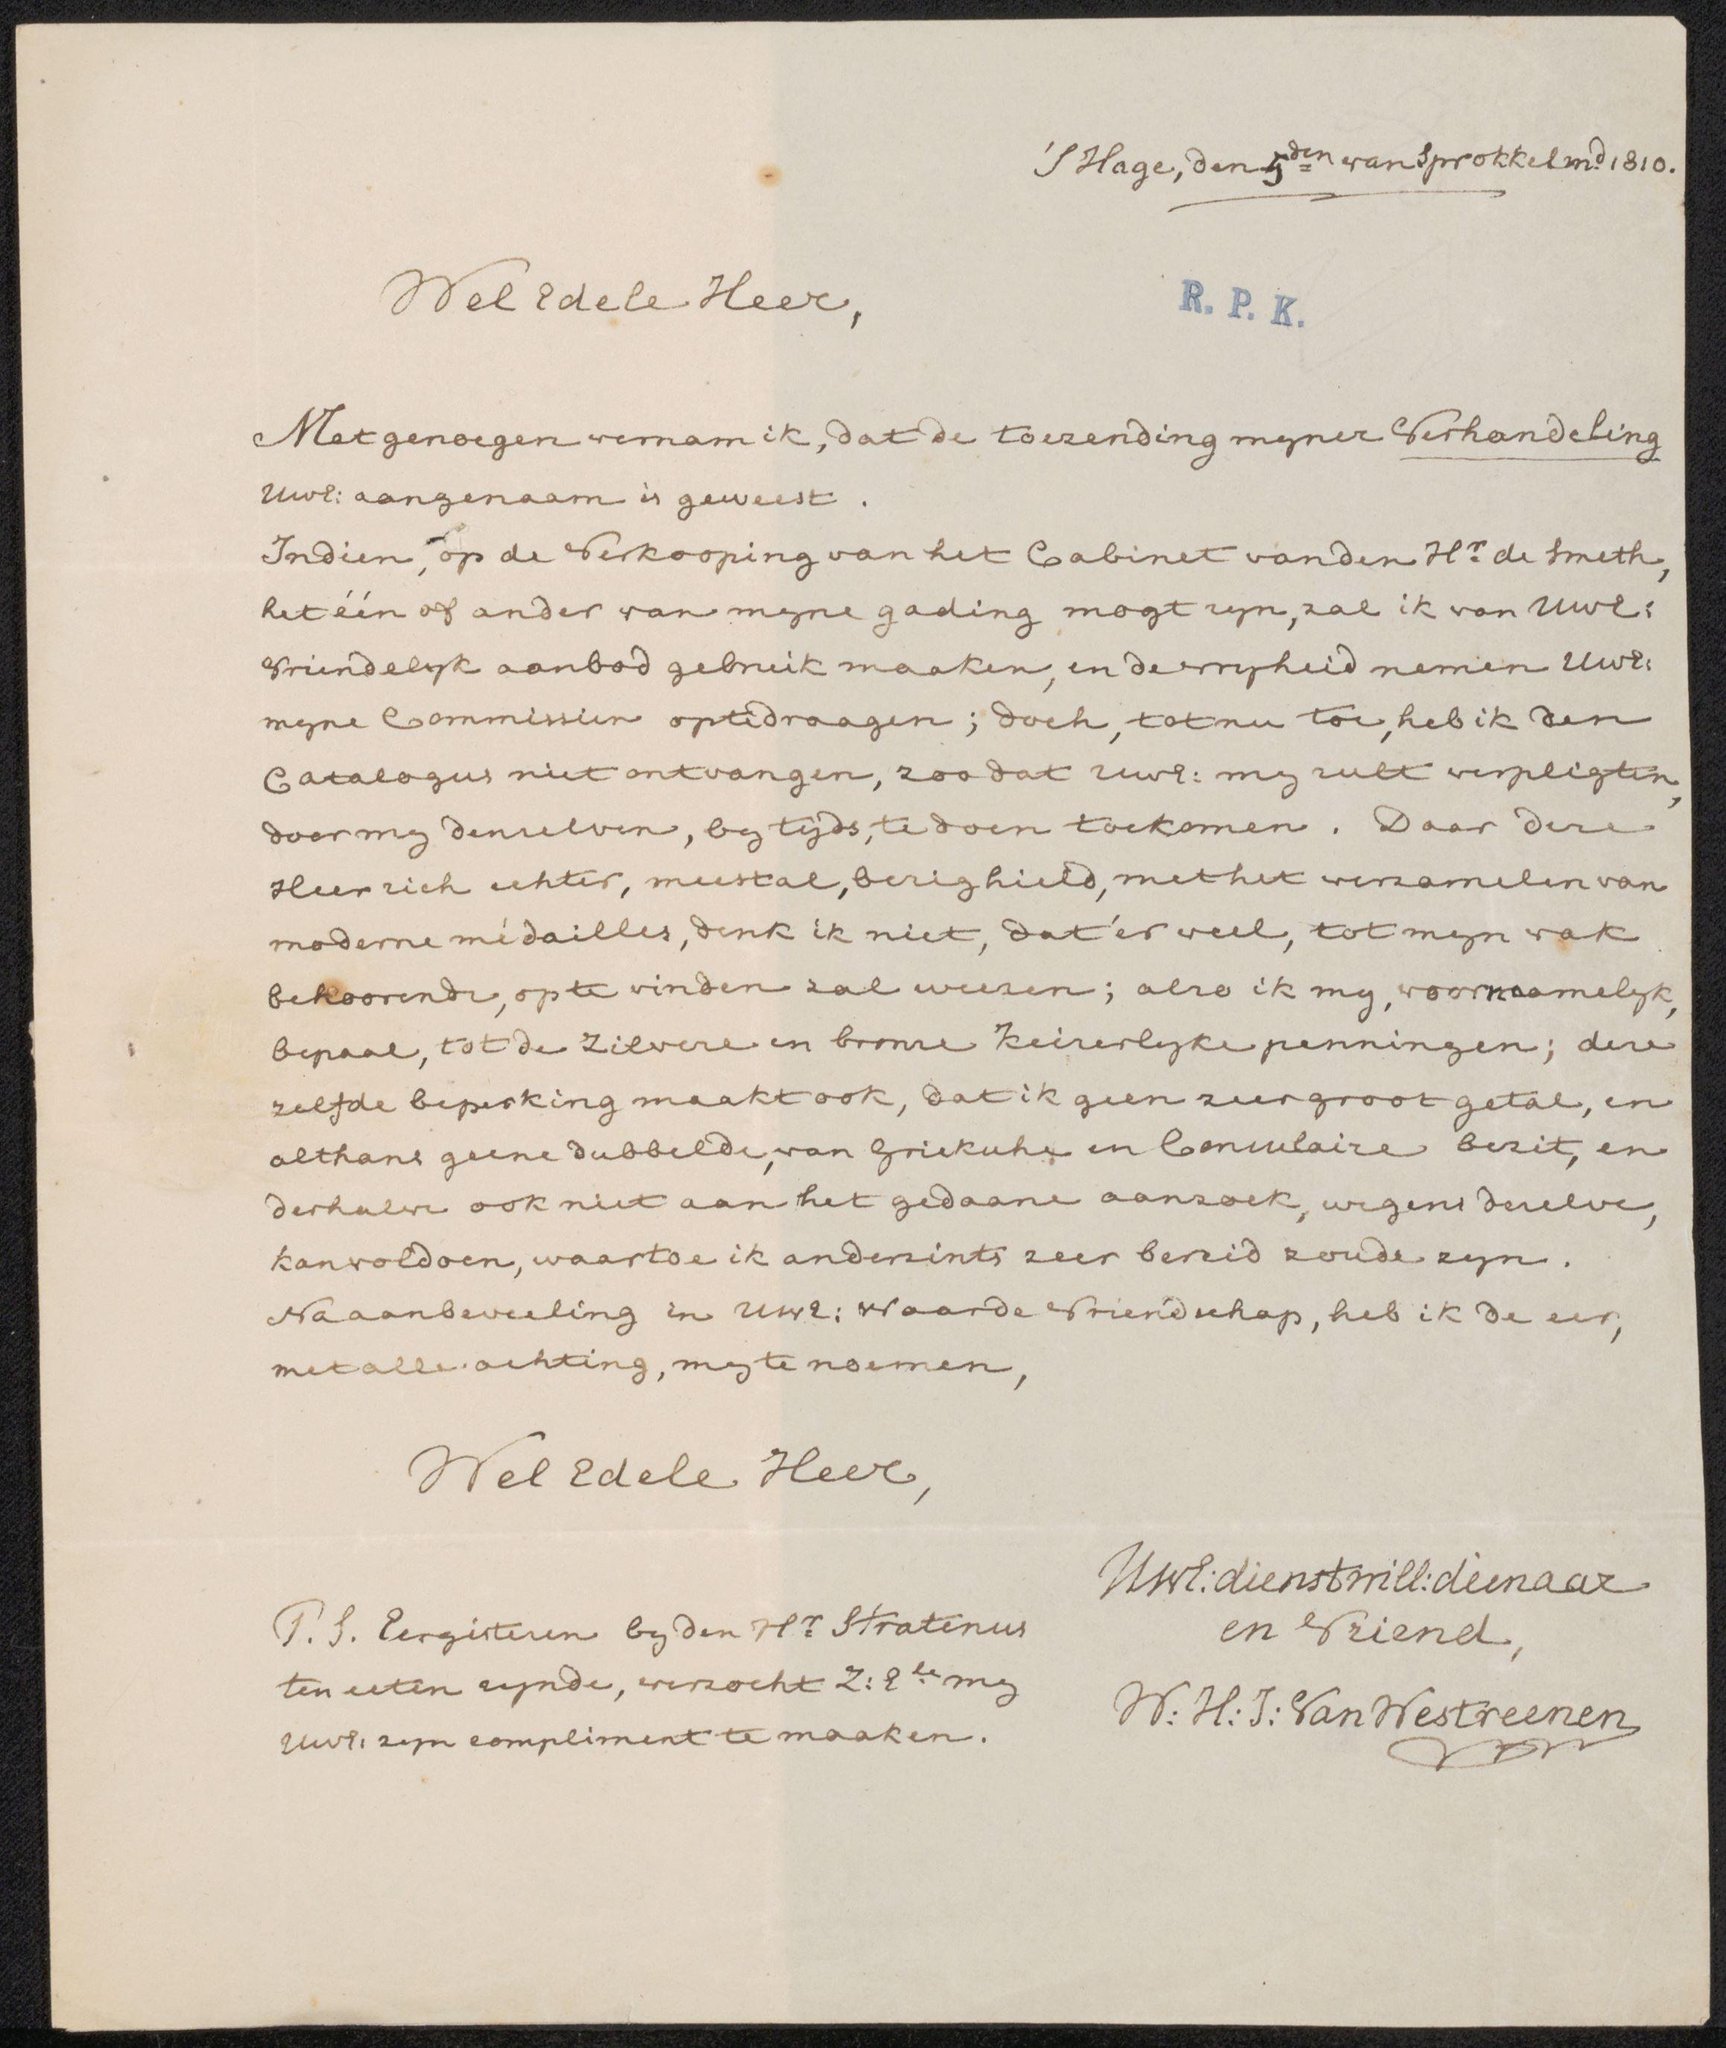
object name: letter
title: Brief aan anoniem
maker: willem hendrik baron van westreenen van tiellandt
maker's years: 1783-1848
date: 1810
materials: ink, paper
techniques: pen, writing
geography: the hague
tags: applied arts, arts and crafts; industrial design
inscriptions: collector's mark: Lugt 2233, seal